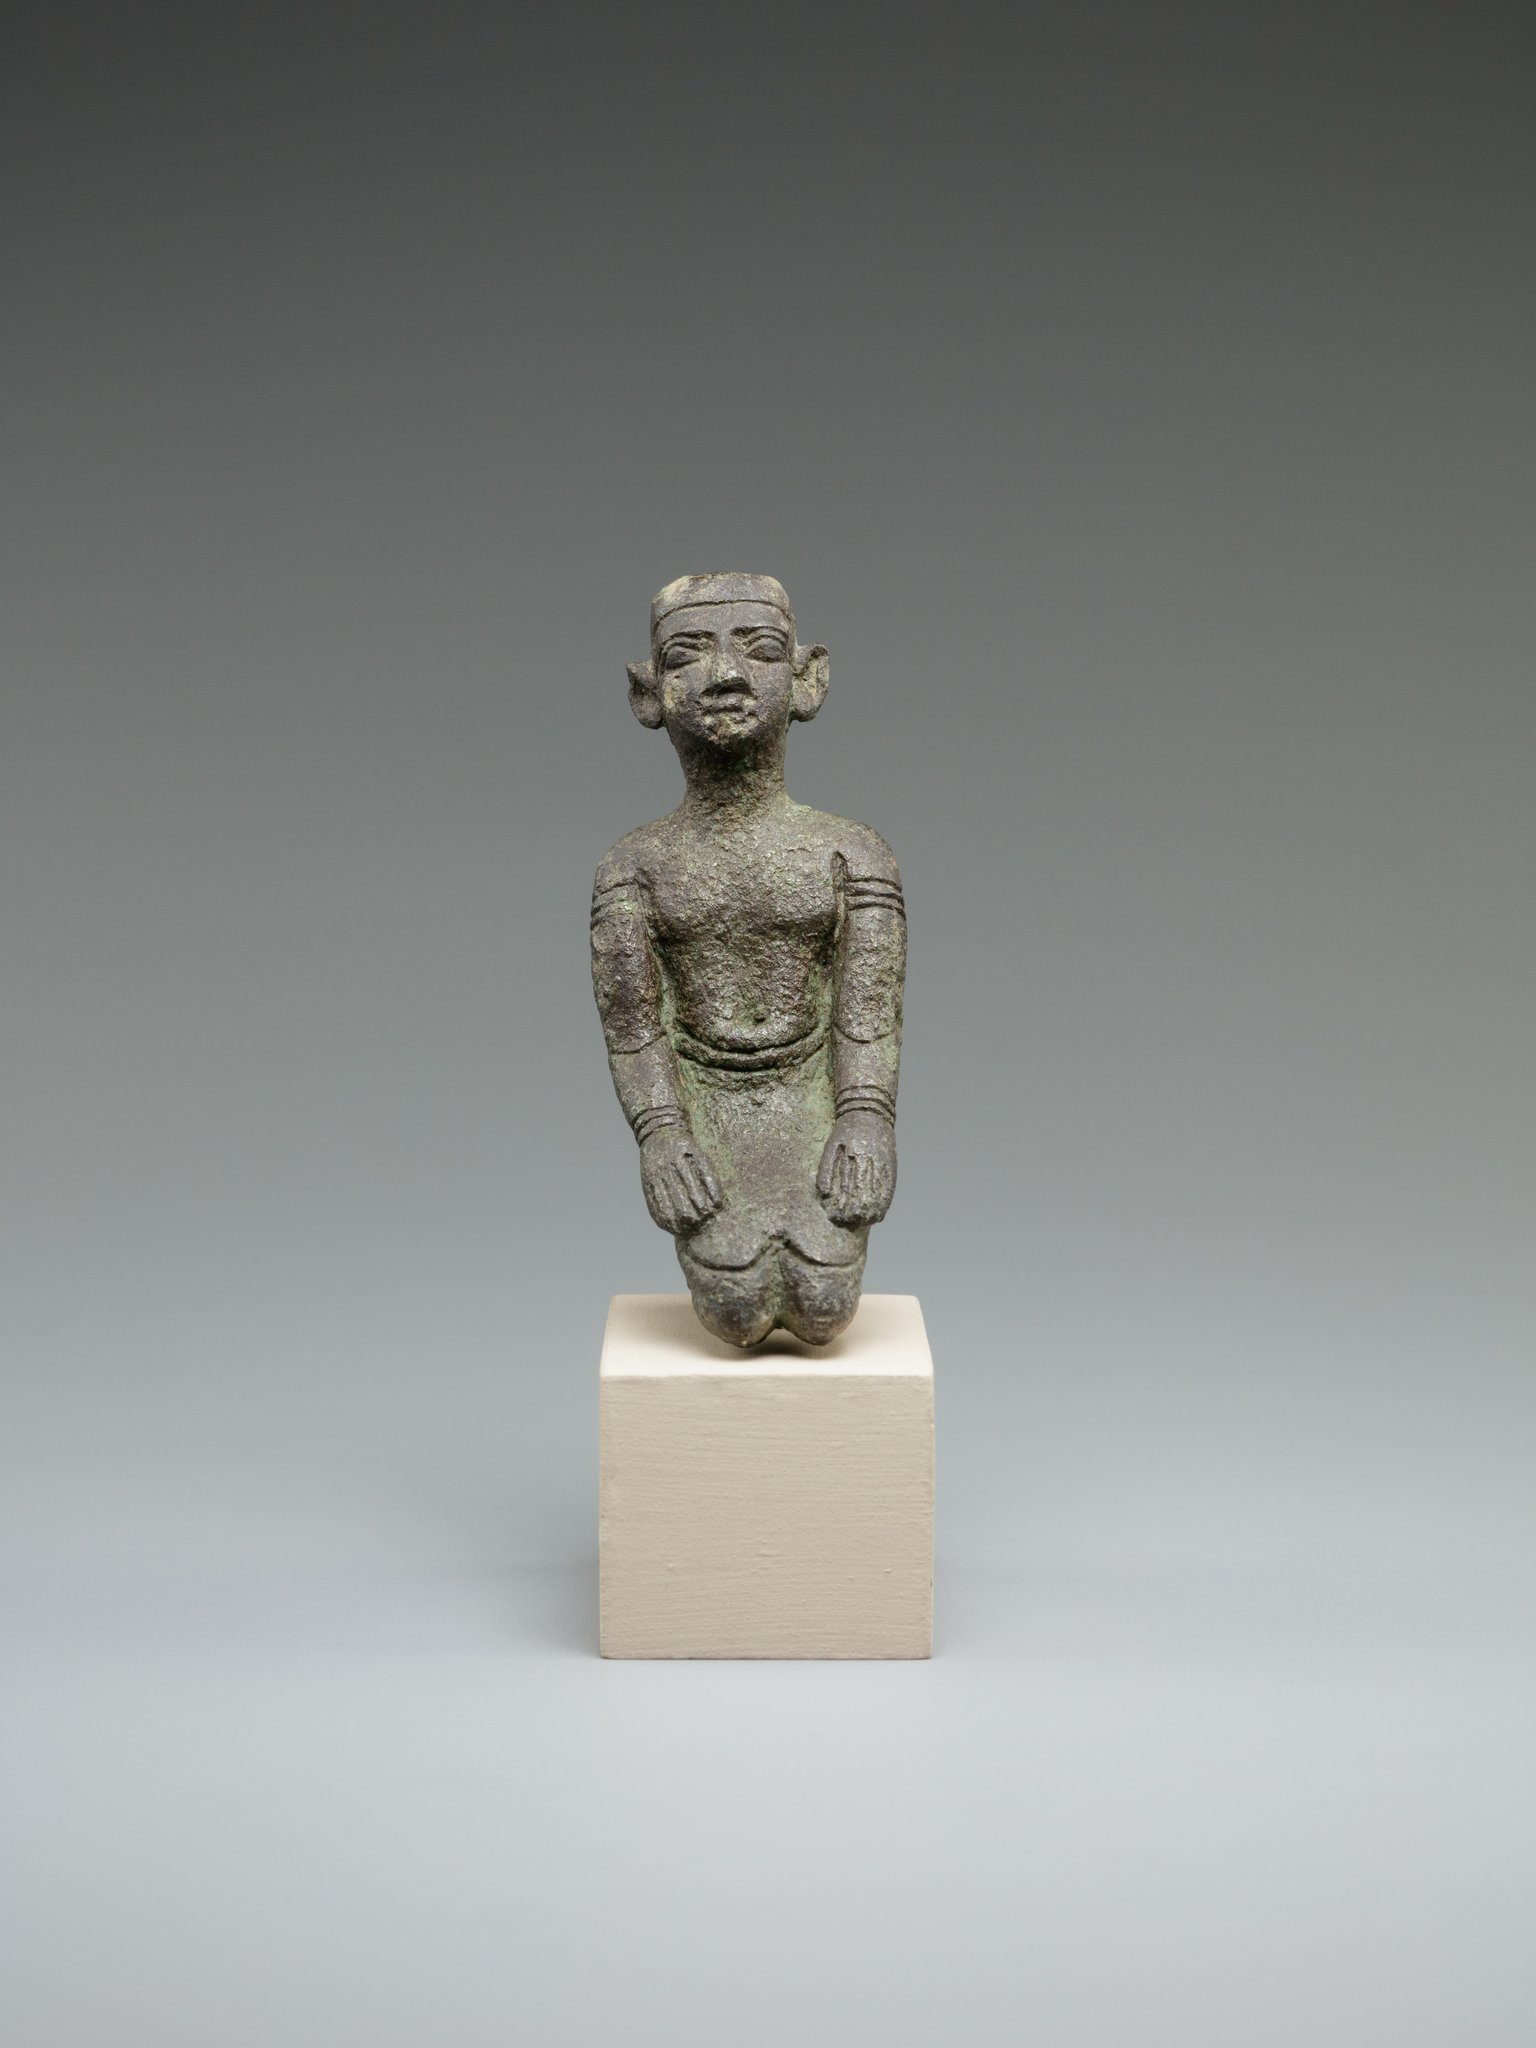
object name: statuette, kneeling priest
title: Kneeling priest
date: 664-630 BCE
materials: alloy, bronze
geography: egypt